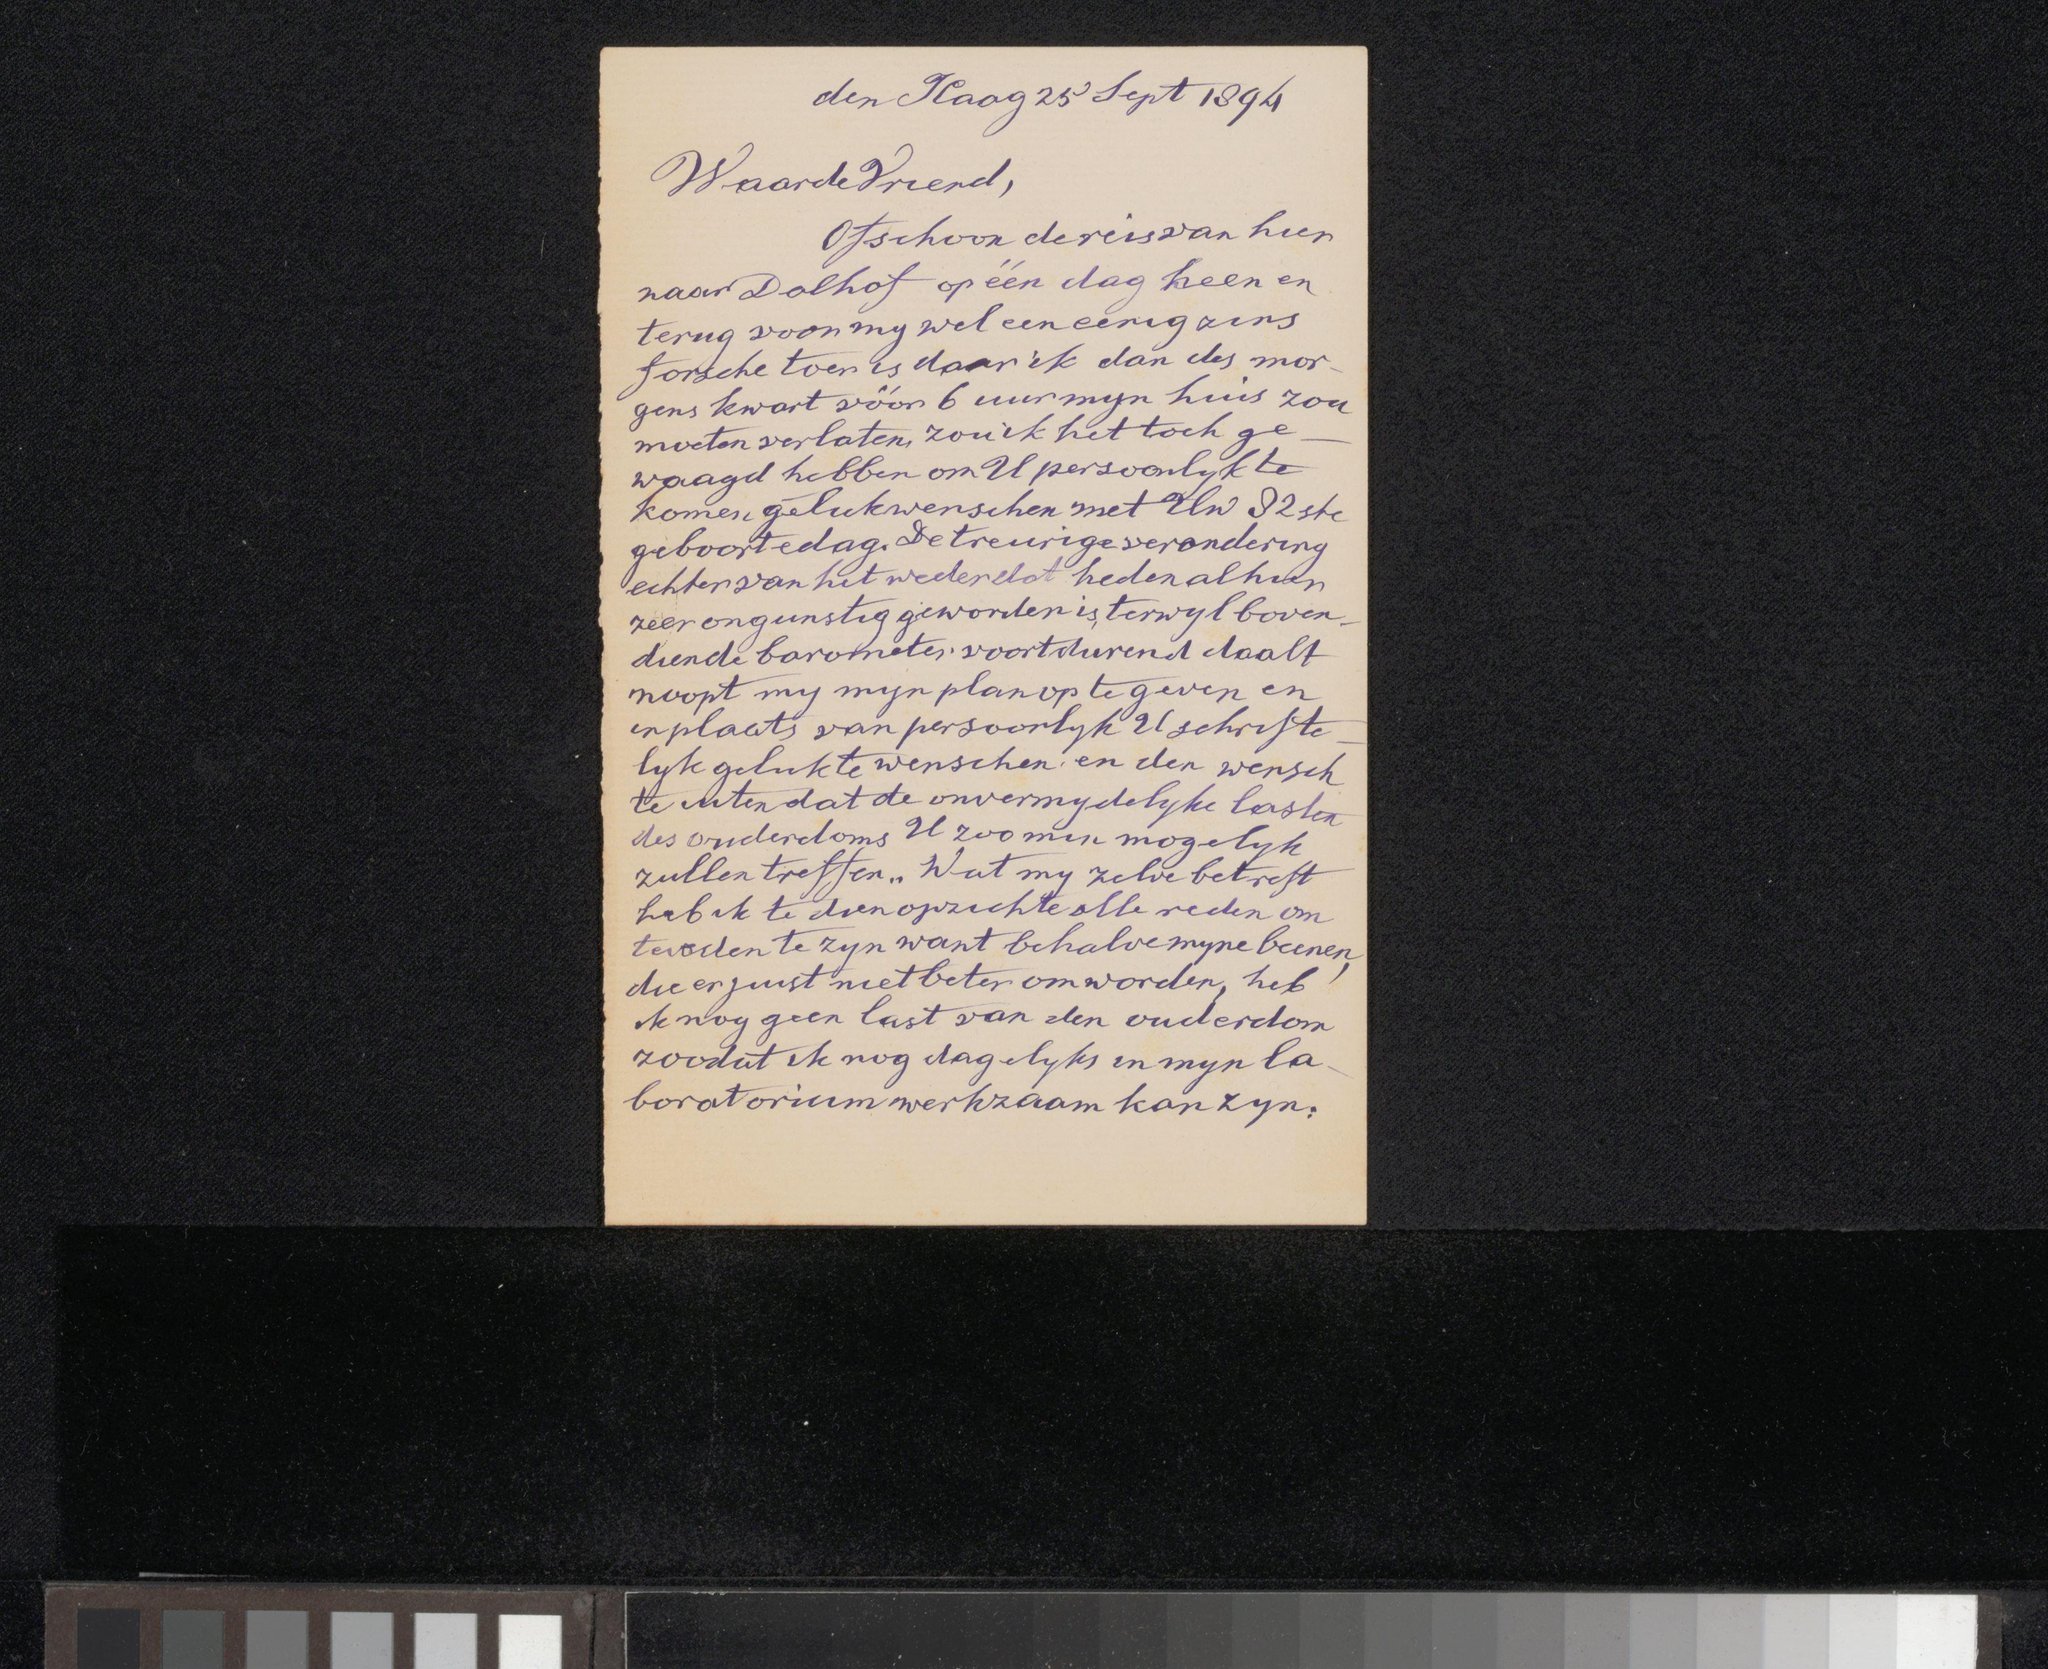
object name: letter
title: Brief aan Ary Johannes Lamme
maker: johan eliza de vrij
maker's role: scheikundige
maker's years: 1813-1898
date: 1894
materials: ink, paper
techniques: pen, writing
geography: the hague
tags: dordrecht, print maker, ary johannes lamme, family life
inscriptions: collector's mark: Lugt 2228